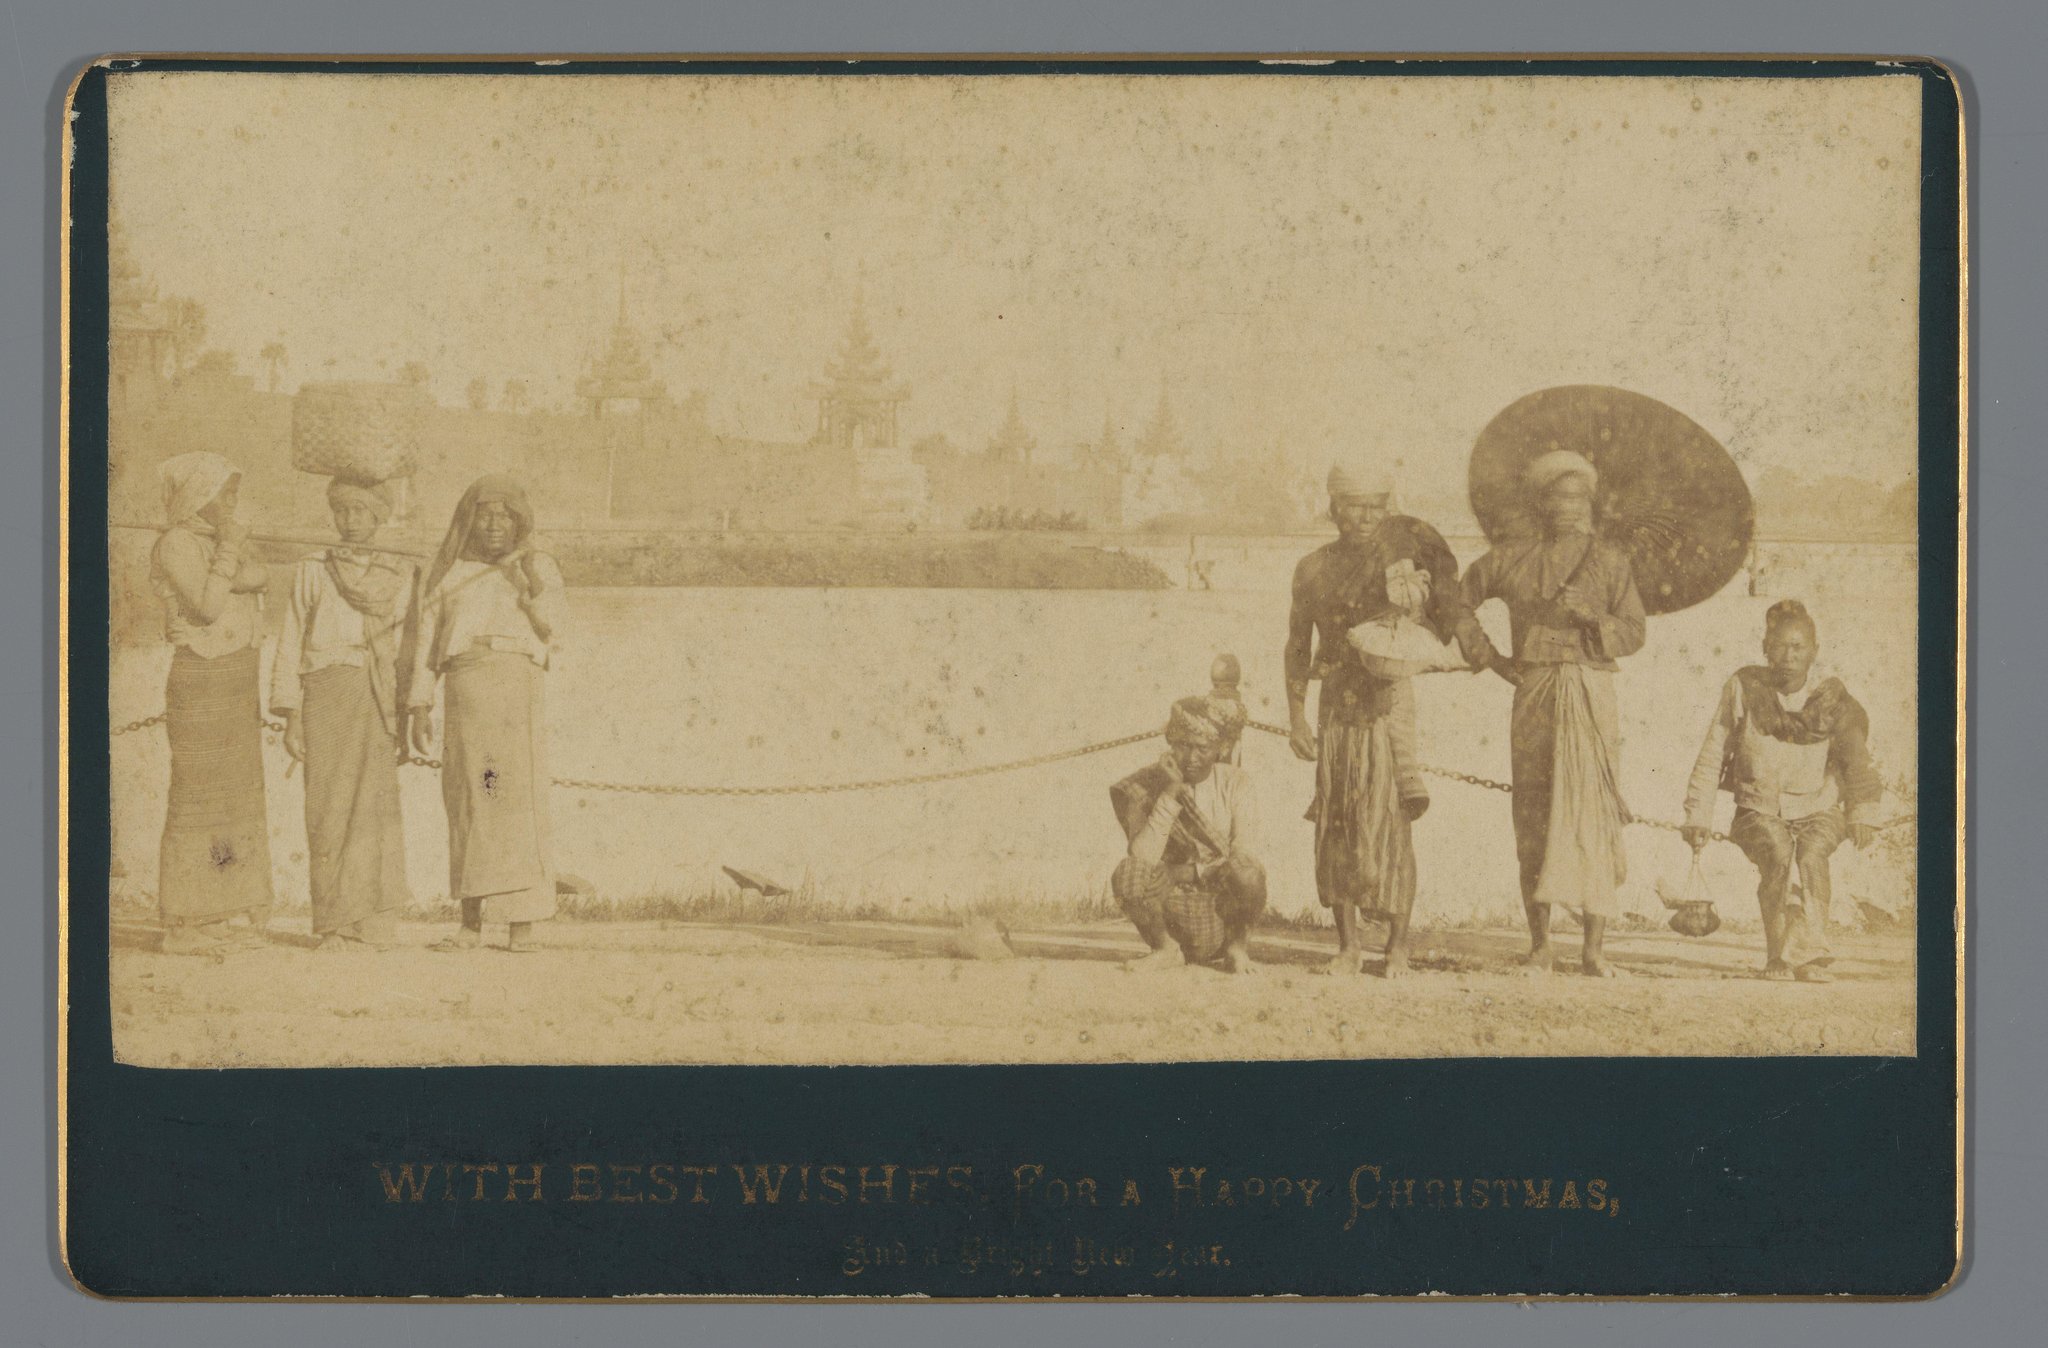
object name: cabinet photograph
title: Kerst- en nieuwjaarswens met Birmezen voor het paleis van Mandalay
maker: Anonymous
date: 1870-1910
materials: cardboard, paper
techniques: albumen print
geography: mandalay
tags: moat ~ fortified city, palace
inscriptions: inscription: ‘With best wishes, for a happy Christmas,/ And a bright New Year.’, number: ‘1023’